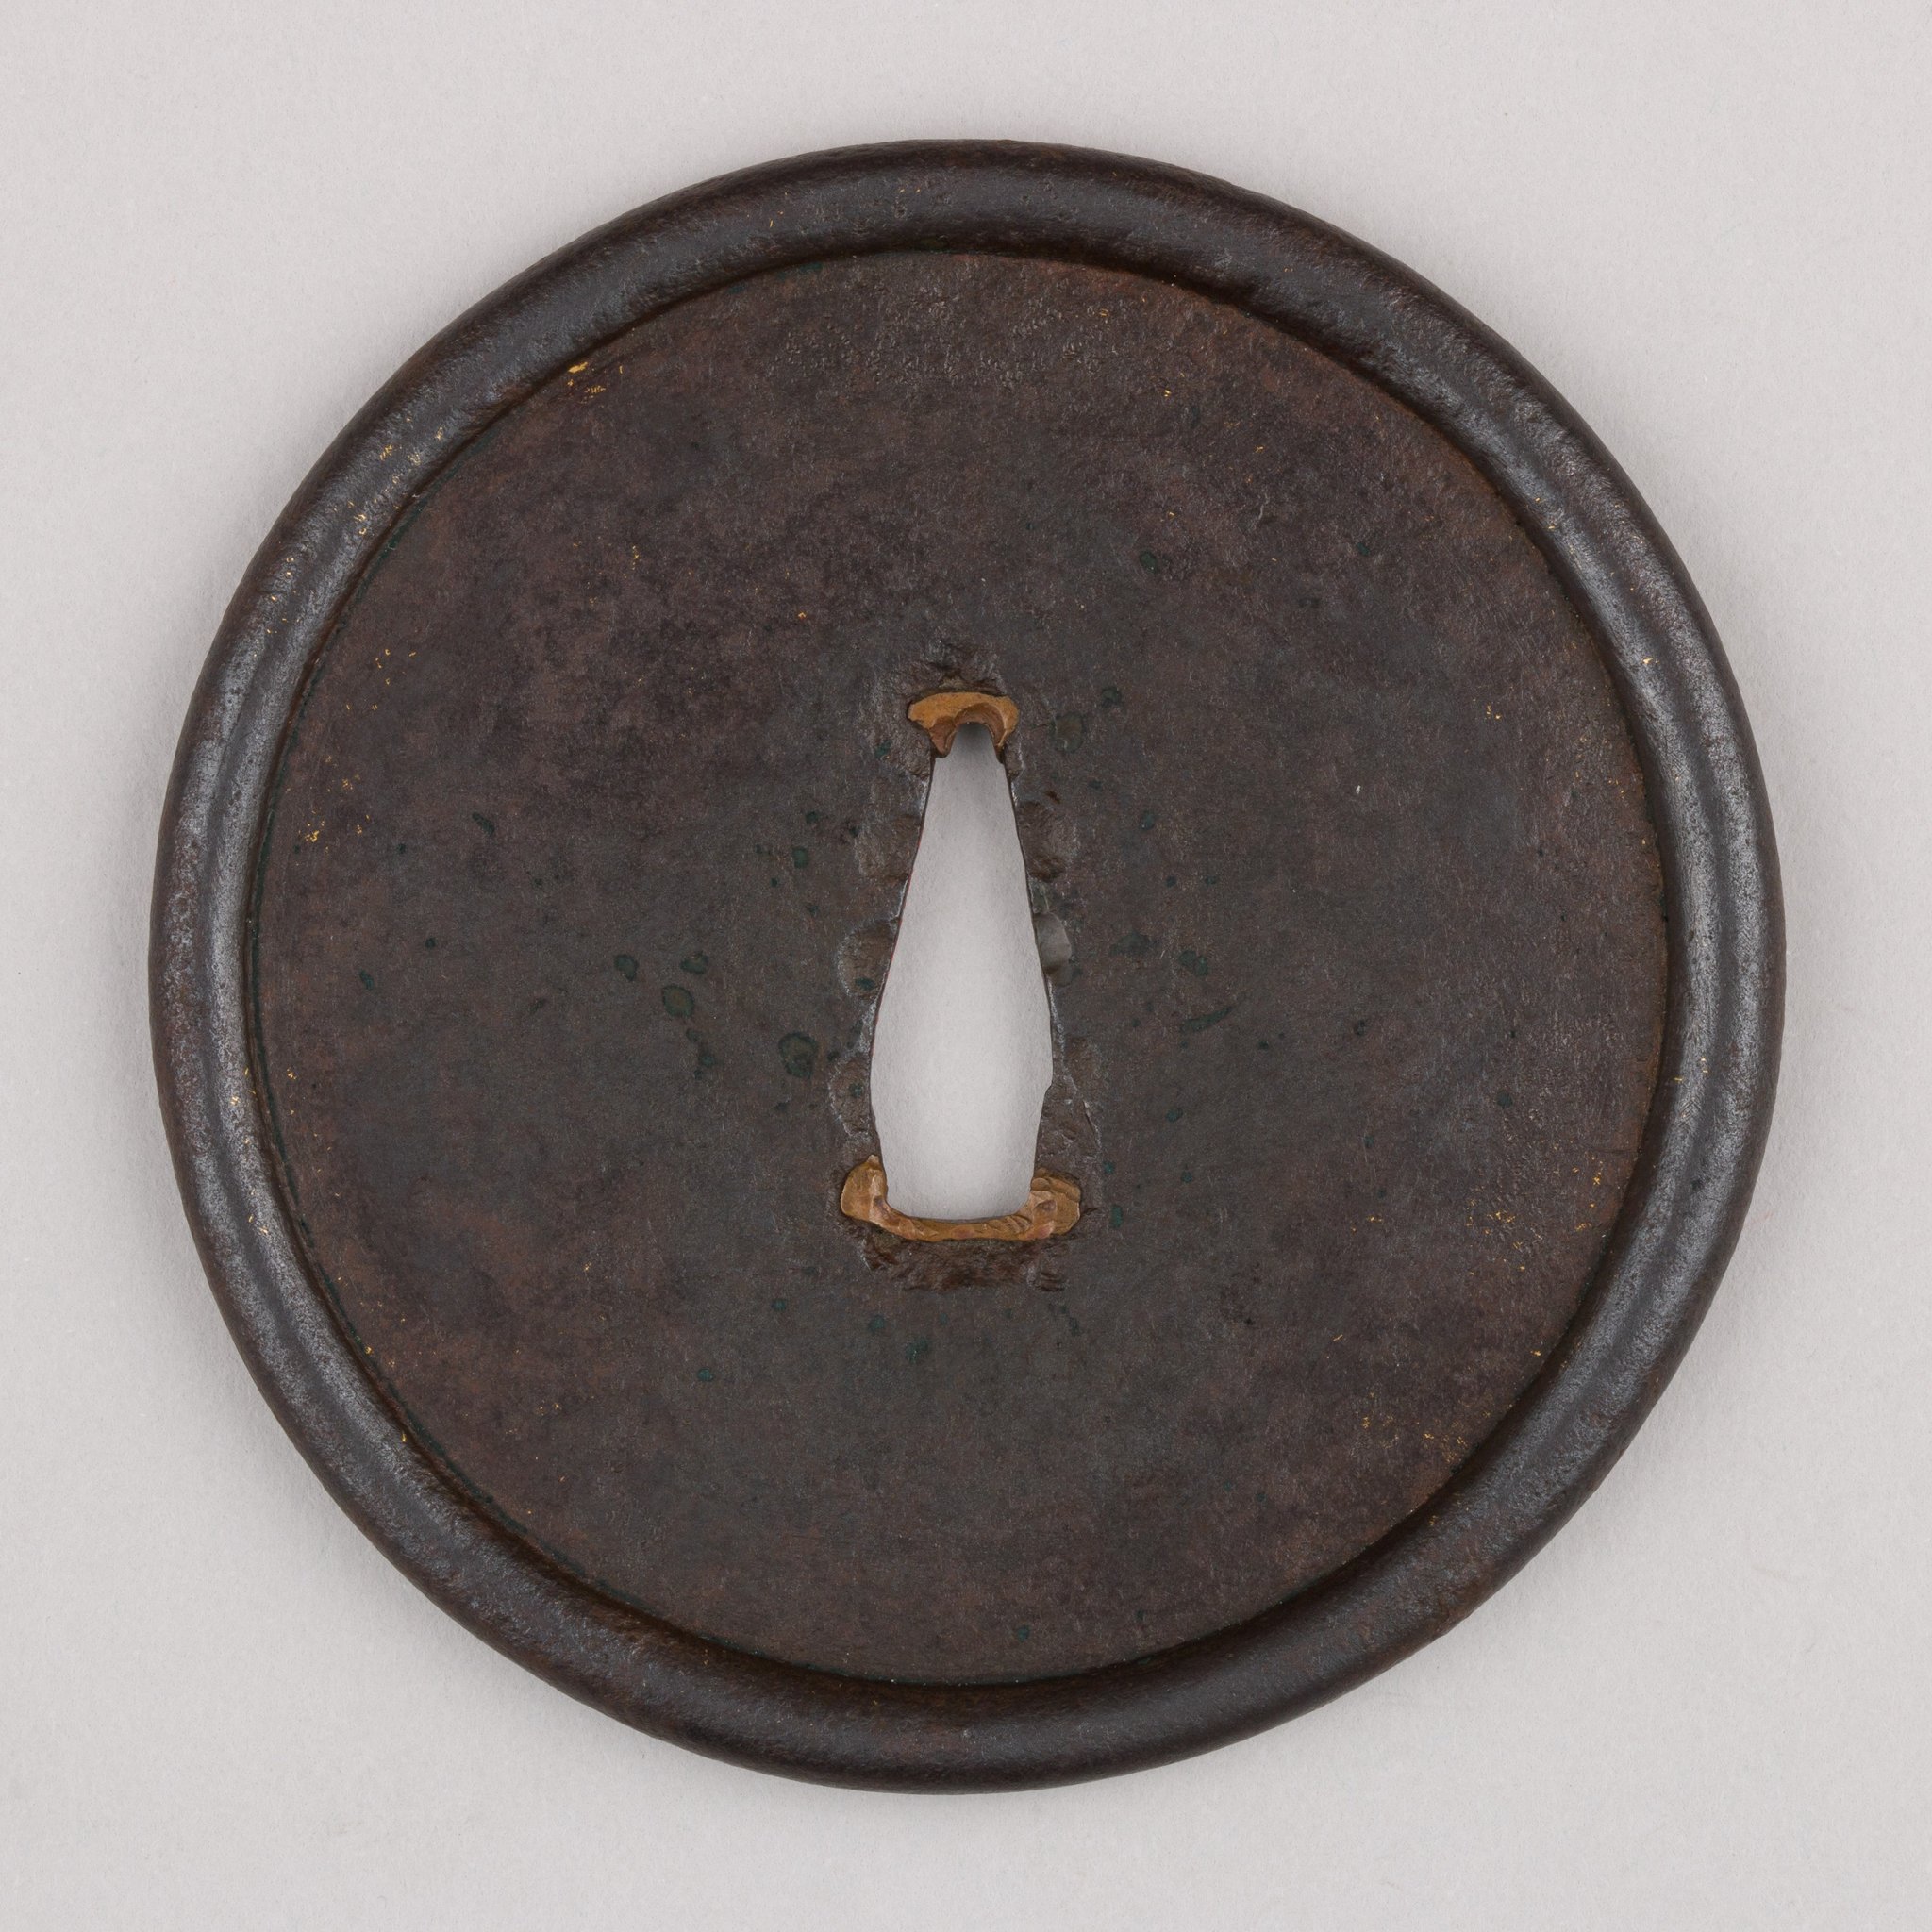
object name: sword guard tsuba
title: Sword Guard (Tsuba)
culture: japanese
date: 1501-1600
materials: copper, gold, iron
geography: japan